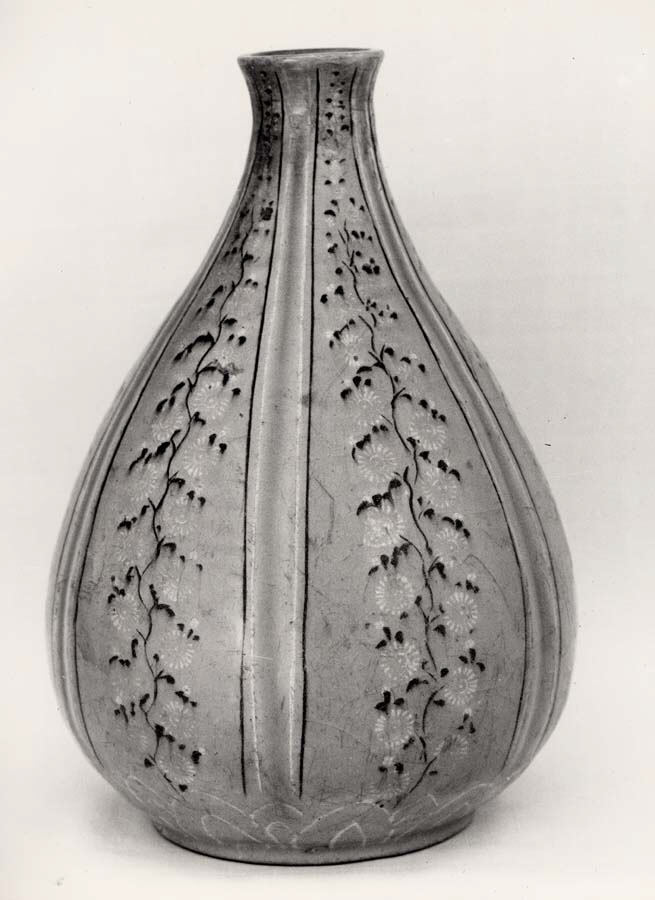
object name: vase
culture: korean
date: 1901-1933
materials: pottery